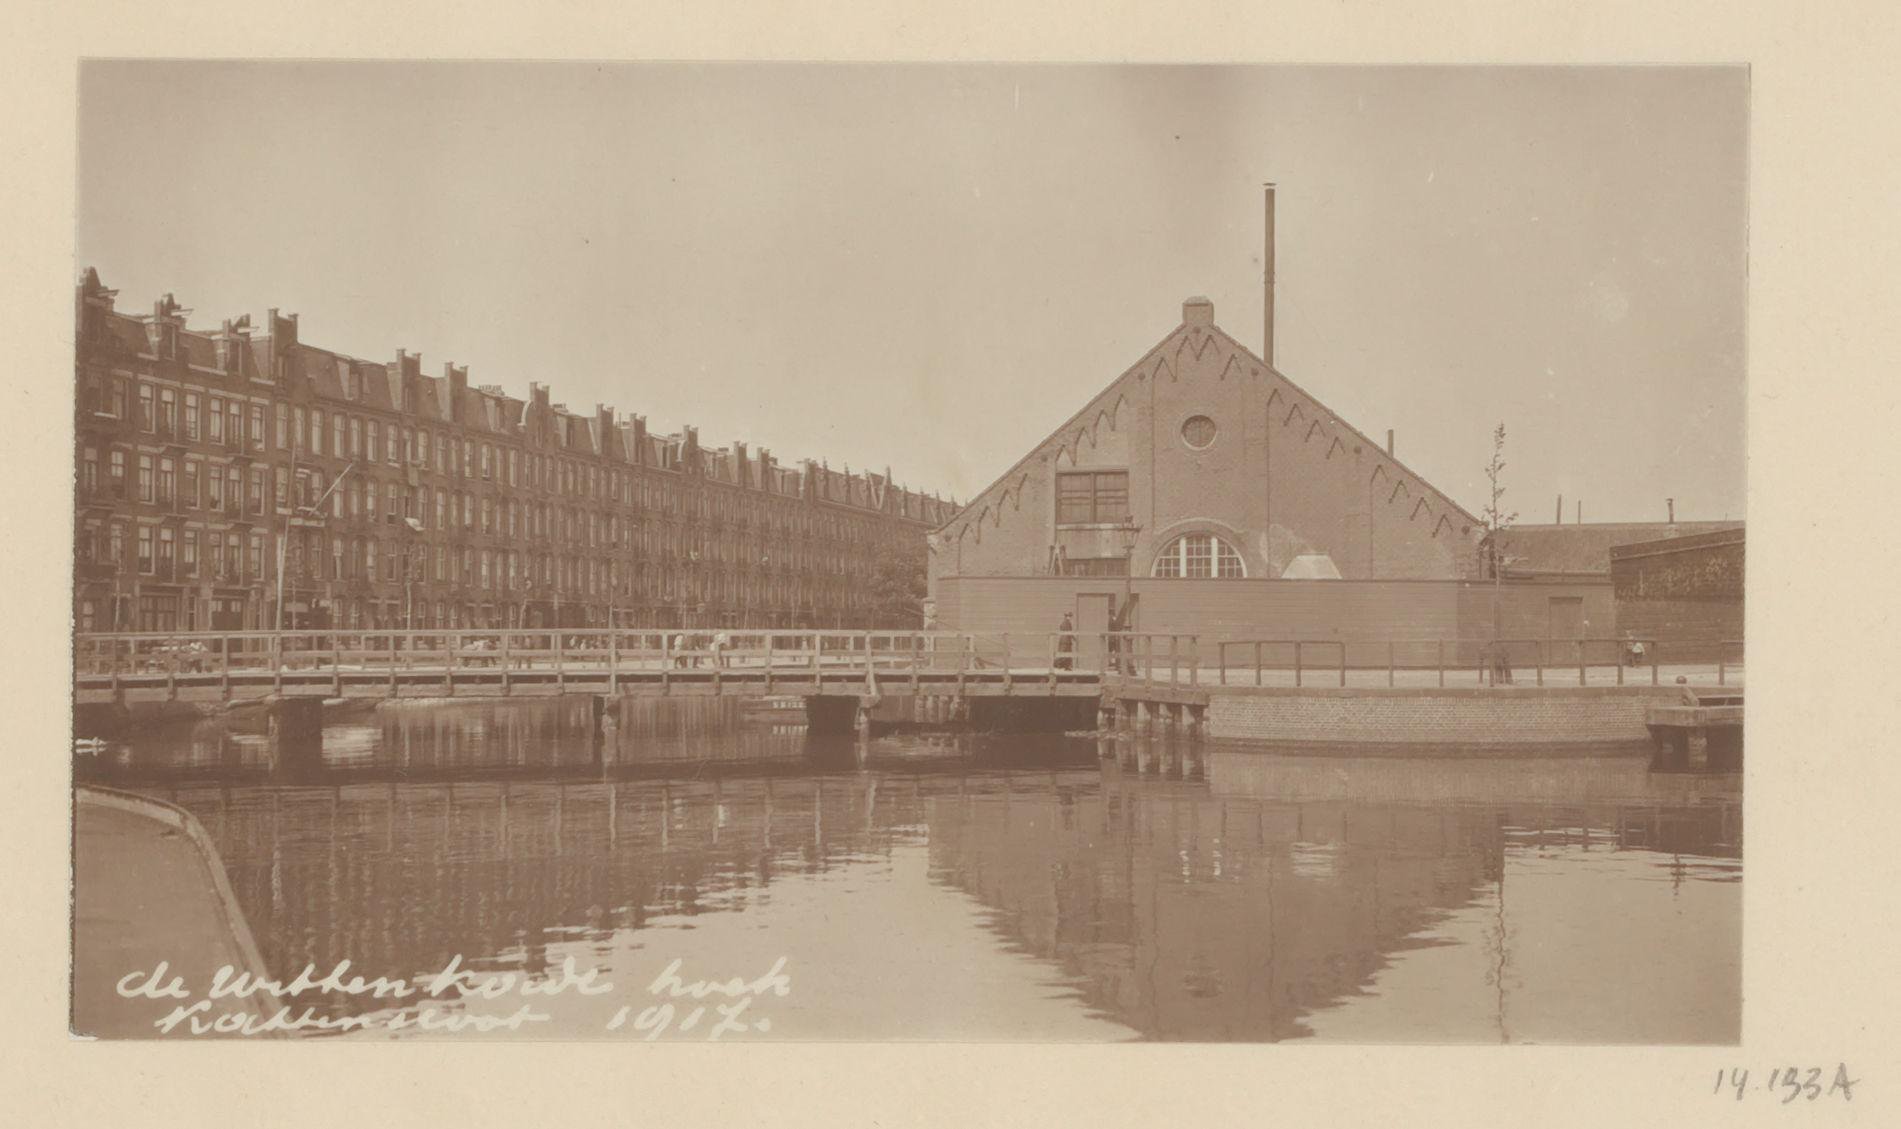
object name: photograph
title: Gezicht op de De Wittenkade, hoek Kostverlorenvaart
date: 1917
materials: cardboard, paper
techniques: albumen print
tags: city-view in general; 'veduta', canal, façade (of house or building), bridge in city across river, canal, etc.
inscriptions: collector's mark: ‘14.133AB’ Lugt 1641b, inscription: ‘De Wittenkade (Kostverlorenvaart) / in 1917. / April 1920. / Geschenk v/d Heer J. van Eck.’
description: Onderwerpsrubriek binnen de Atlas Amsterdam: Waal (Kromme en Oude), Walenpleintje, Warmoesgracht, Warmoesstraat, Waterlooplein, Westerdoksdijk, Westermarkt, Weteringschans, Willemspark, Willemsstraat, Wittenburg, Wittenkade (de), Wittenstraat (de).